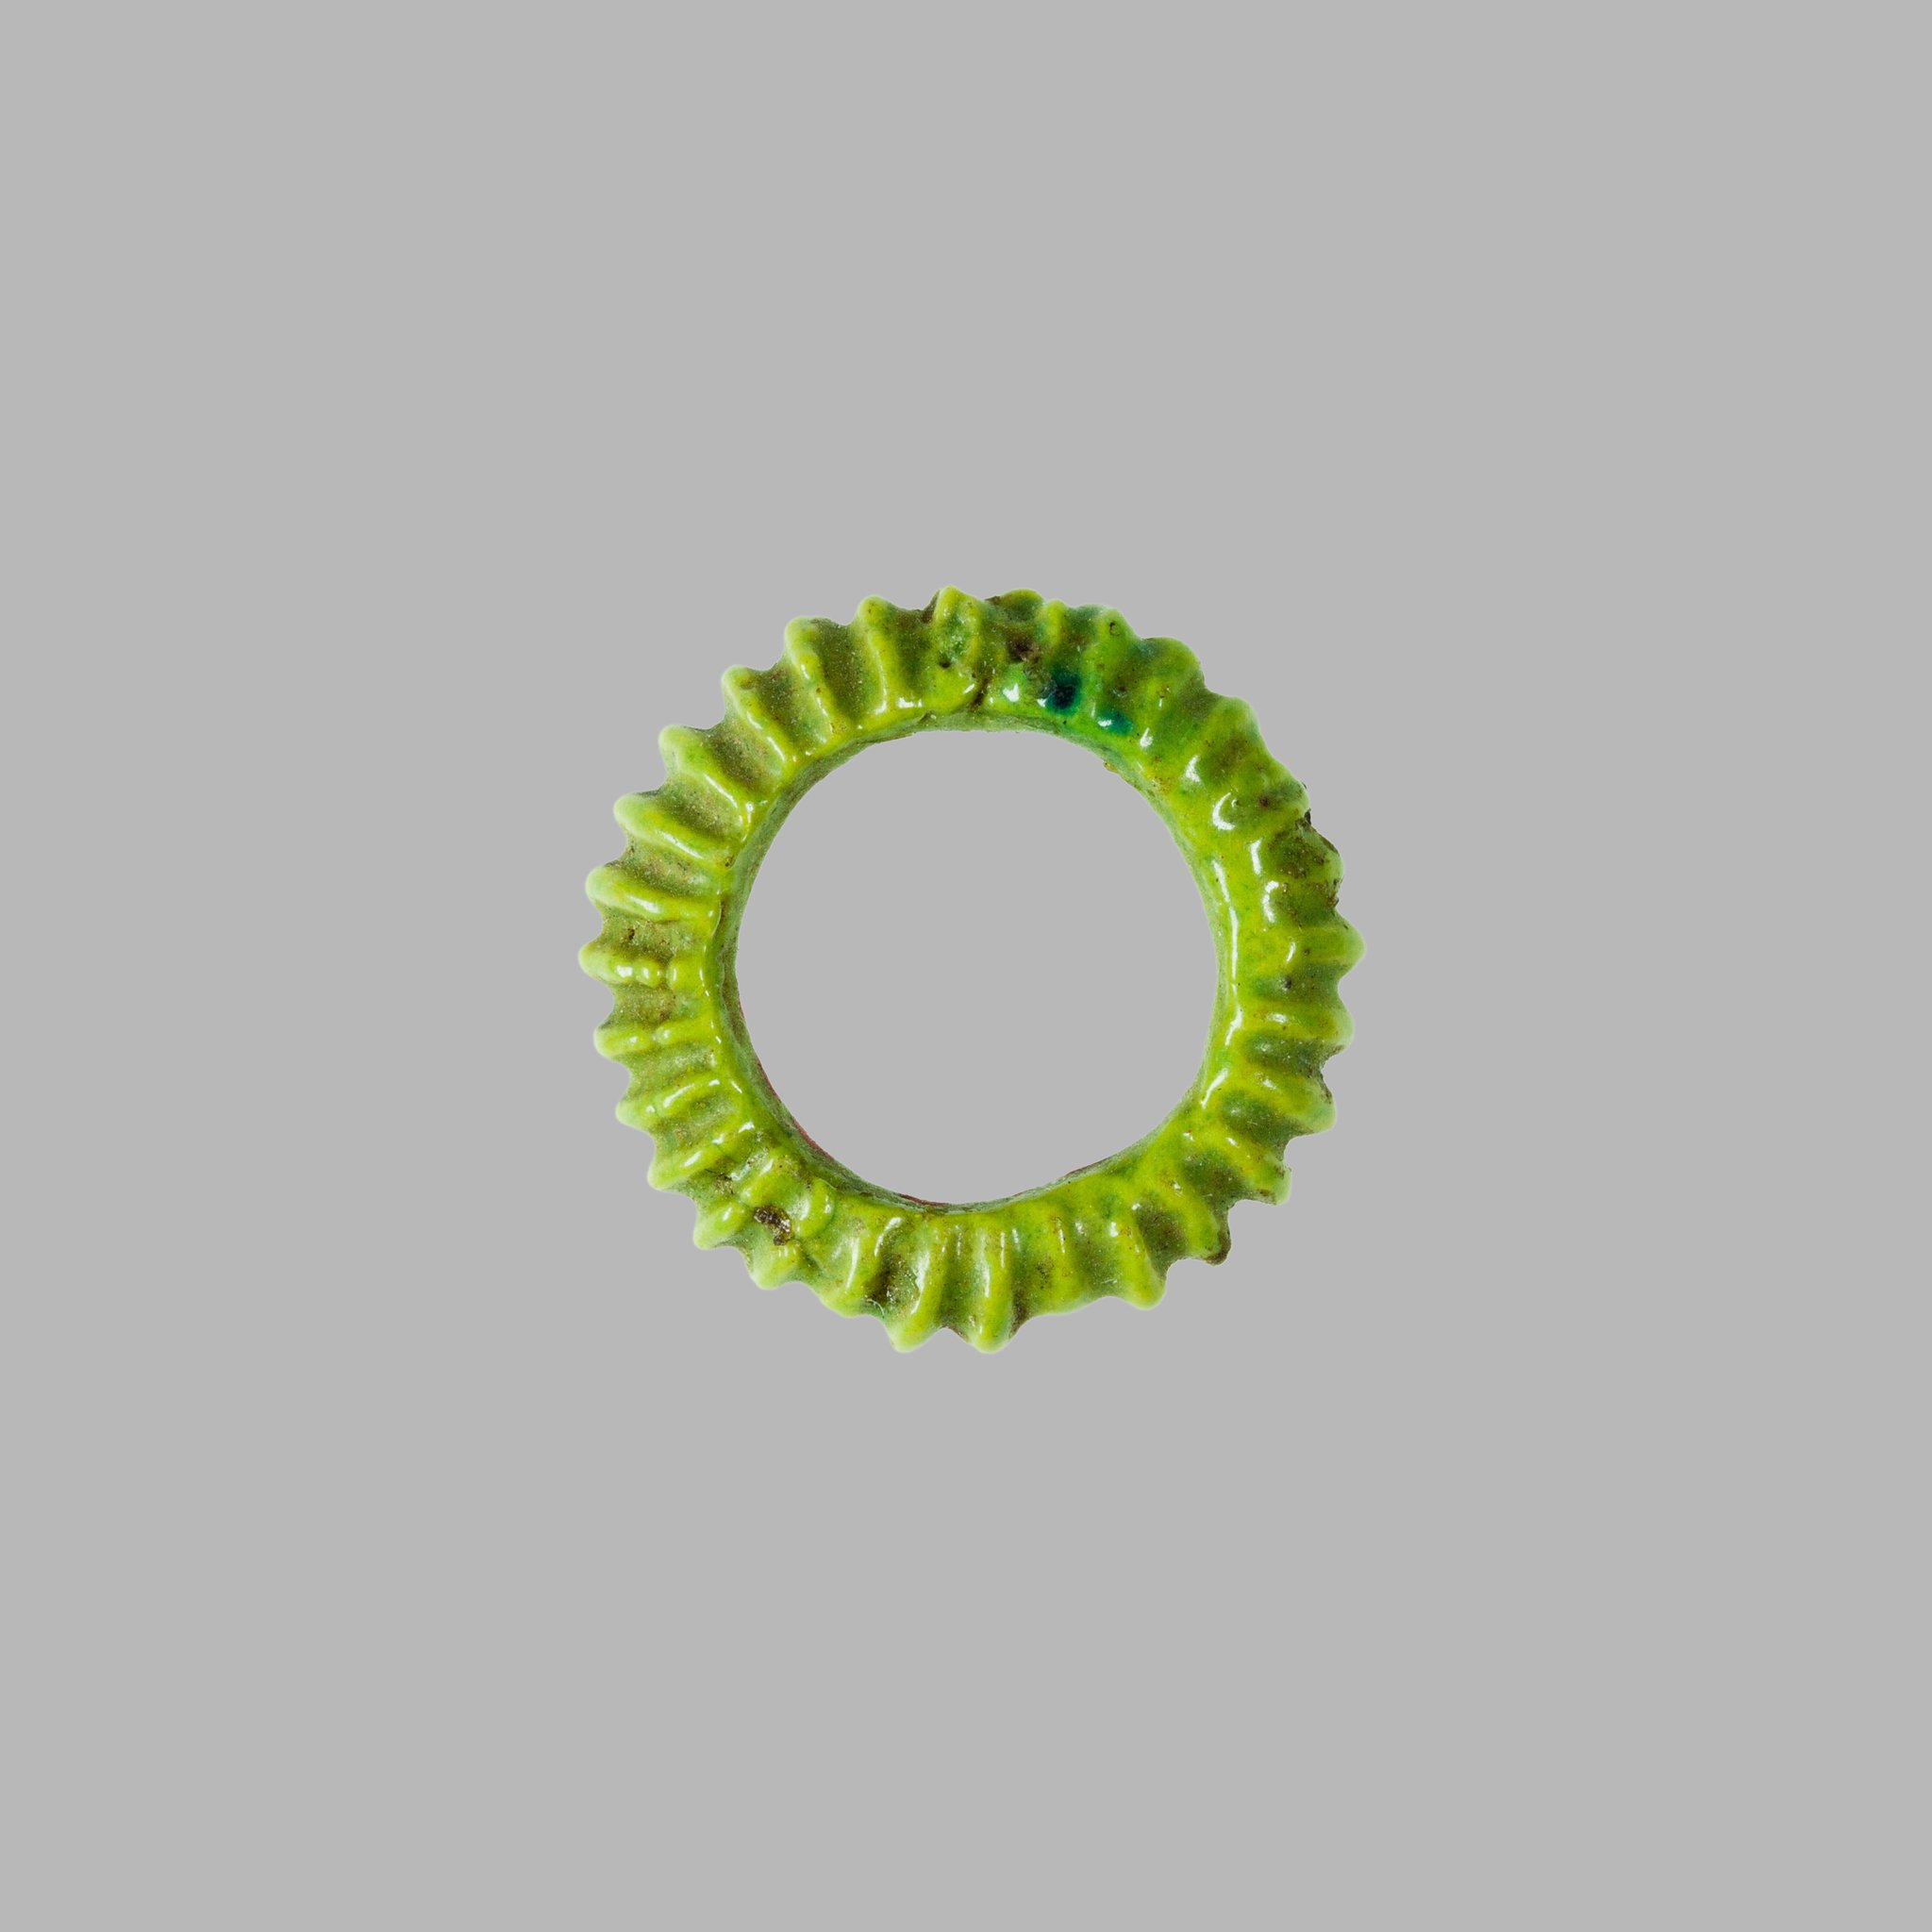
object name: pendant, rosette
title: Rosette Pendant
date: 1353-1336 BCE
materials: faience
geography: egypt